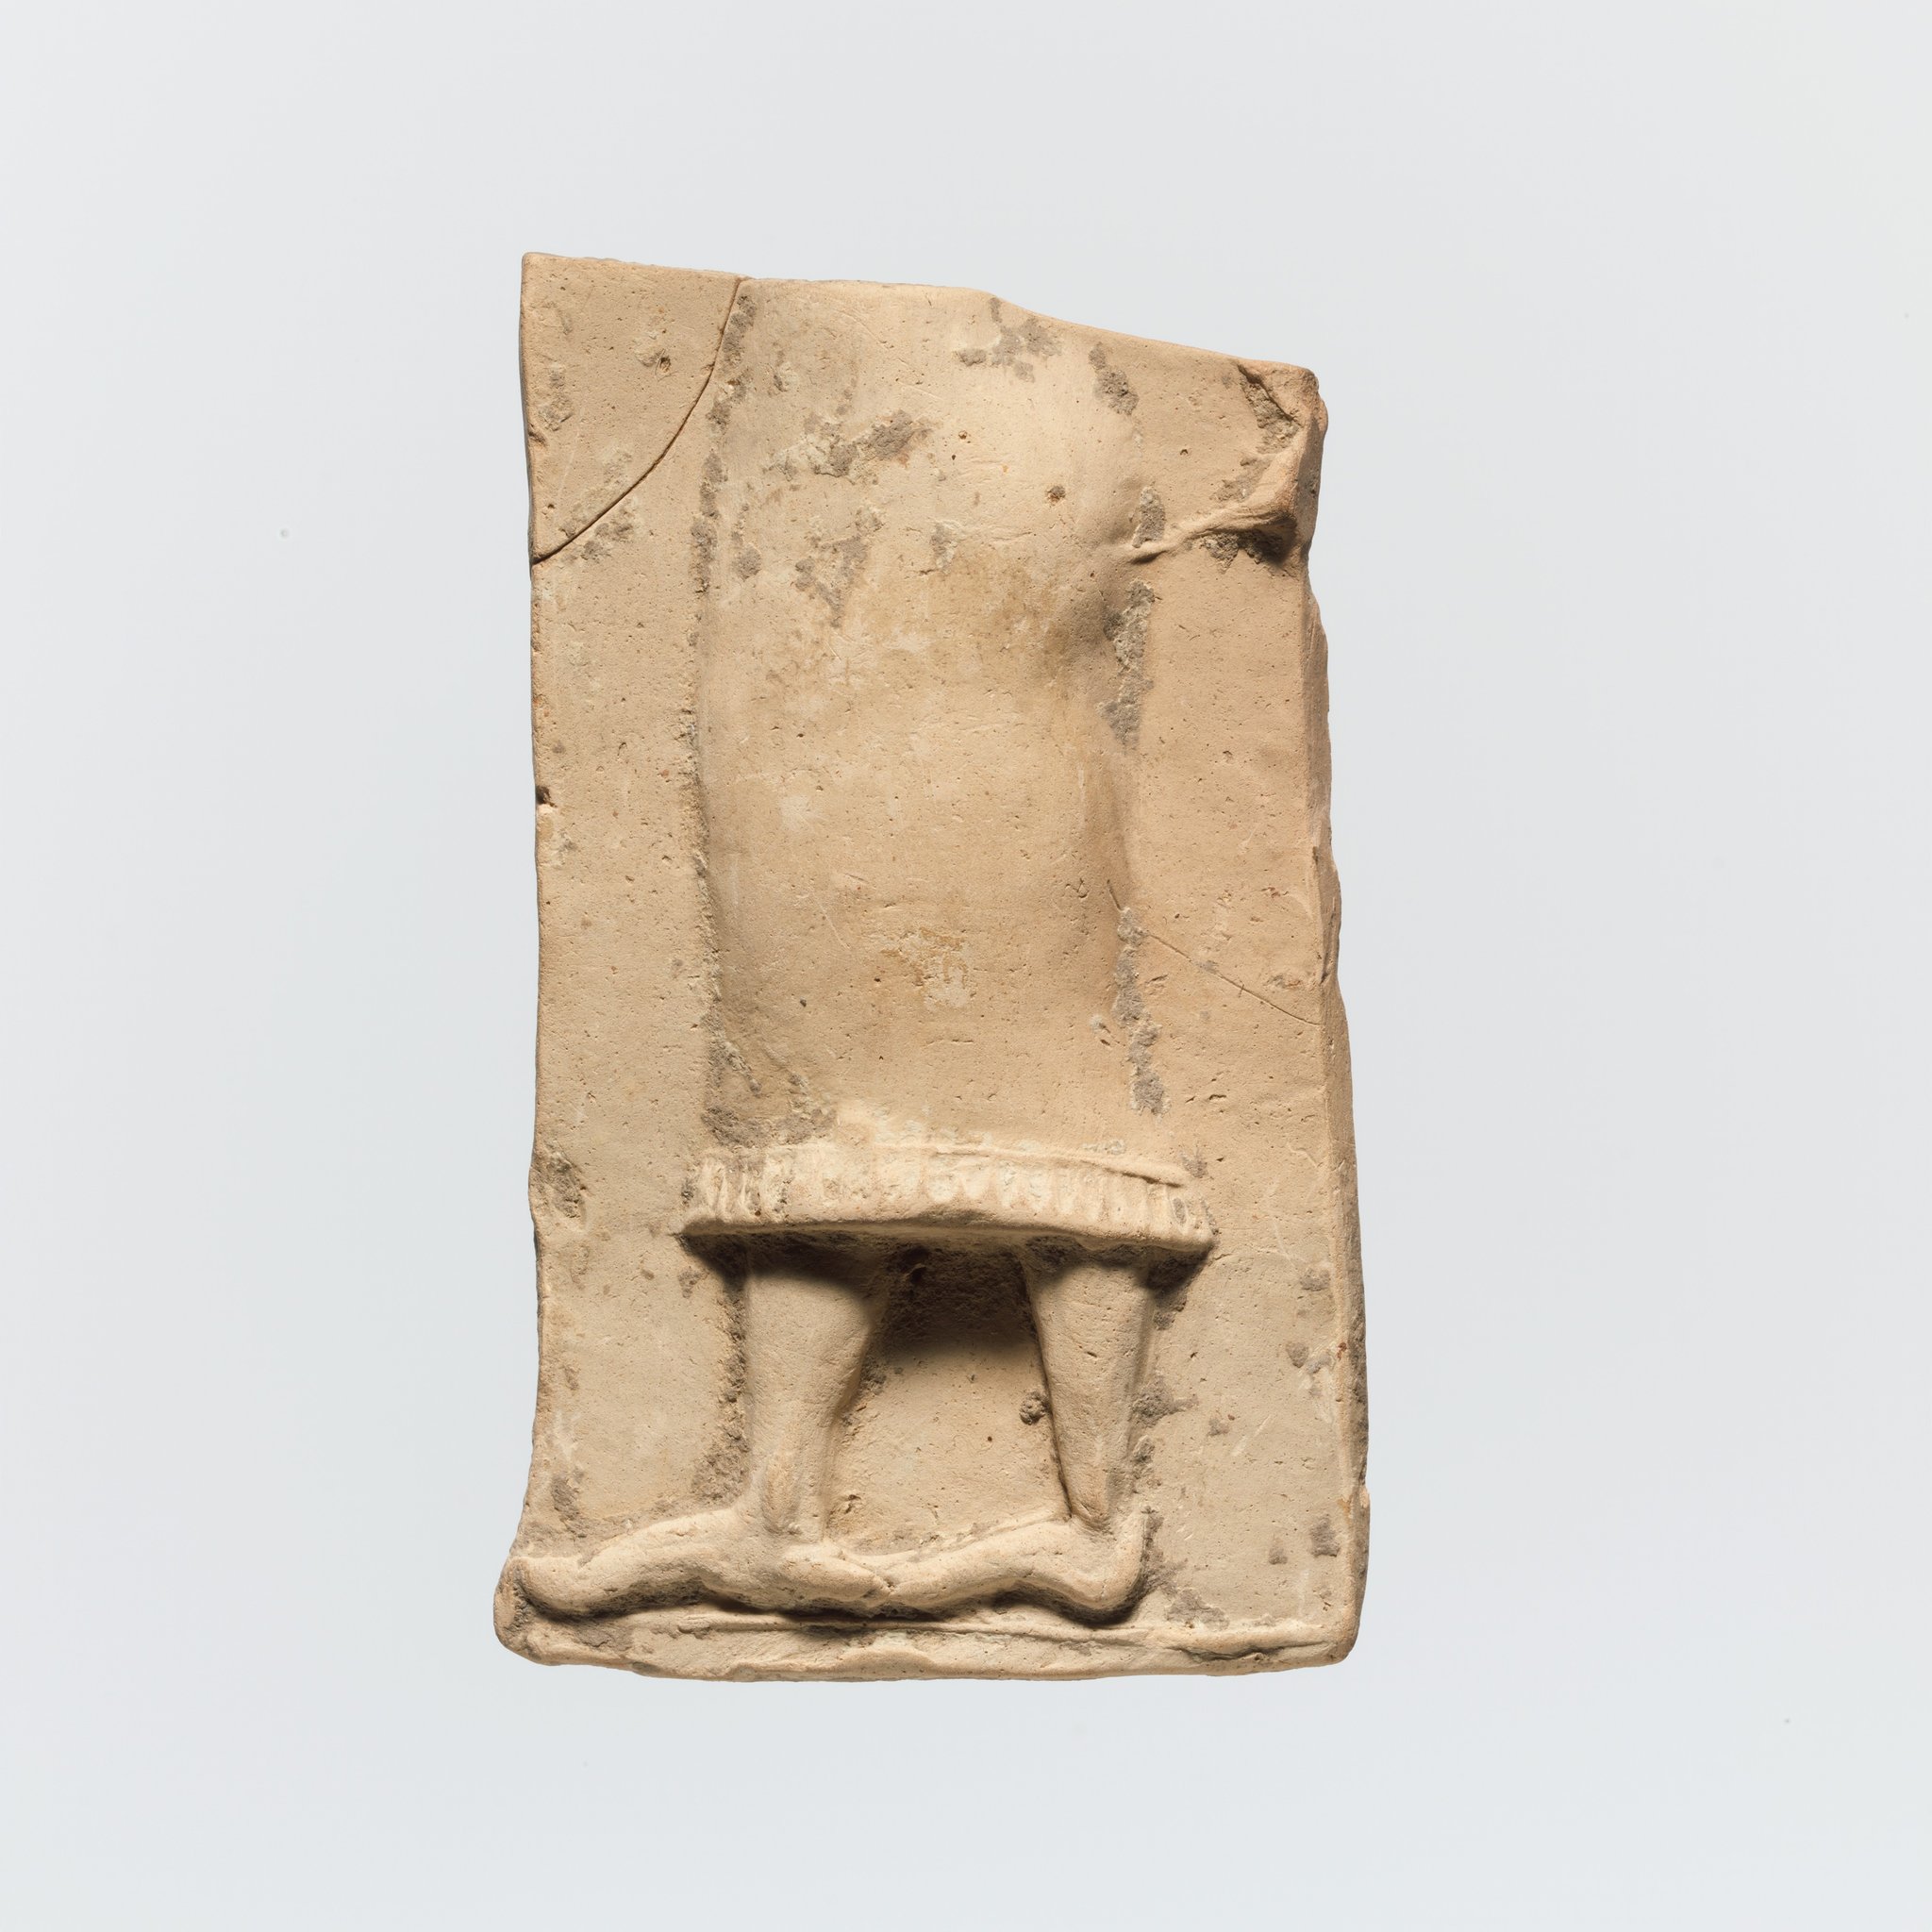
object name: pinax, figure in tunic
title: Fragment of a terracotta plaque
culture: greek, cretan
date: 700-601 BCE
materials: terracotta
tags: men